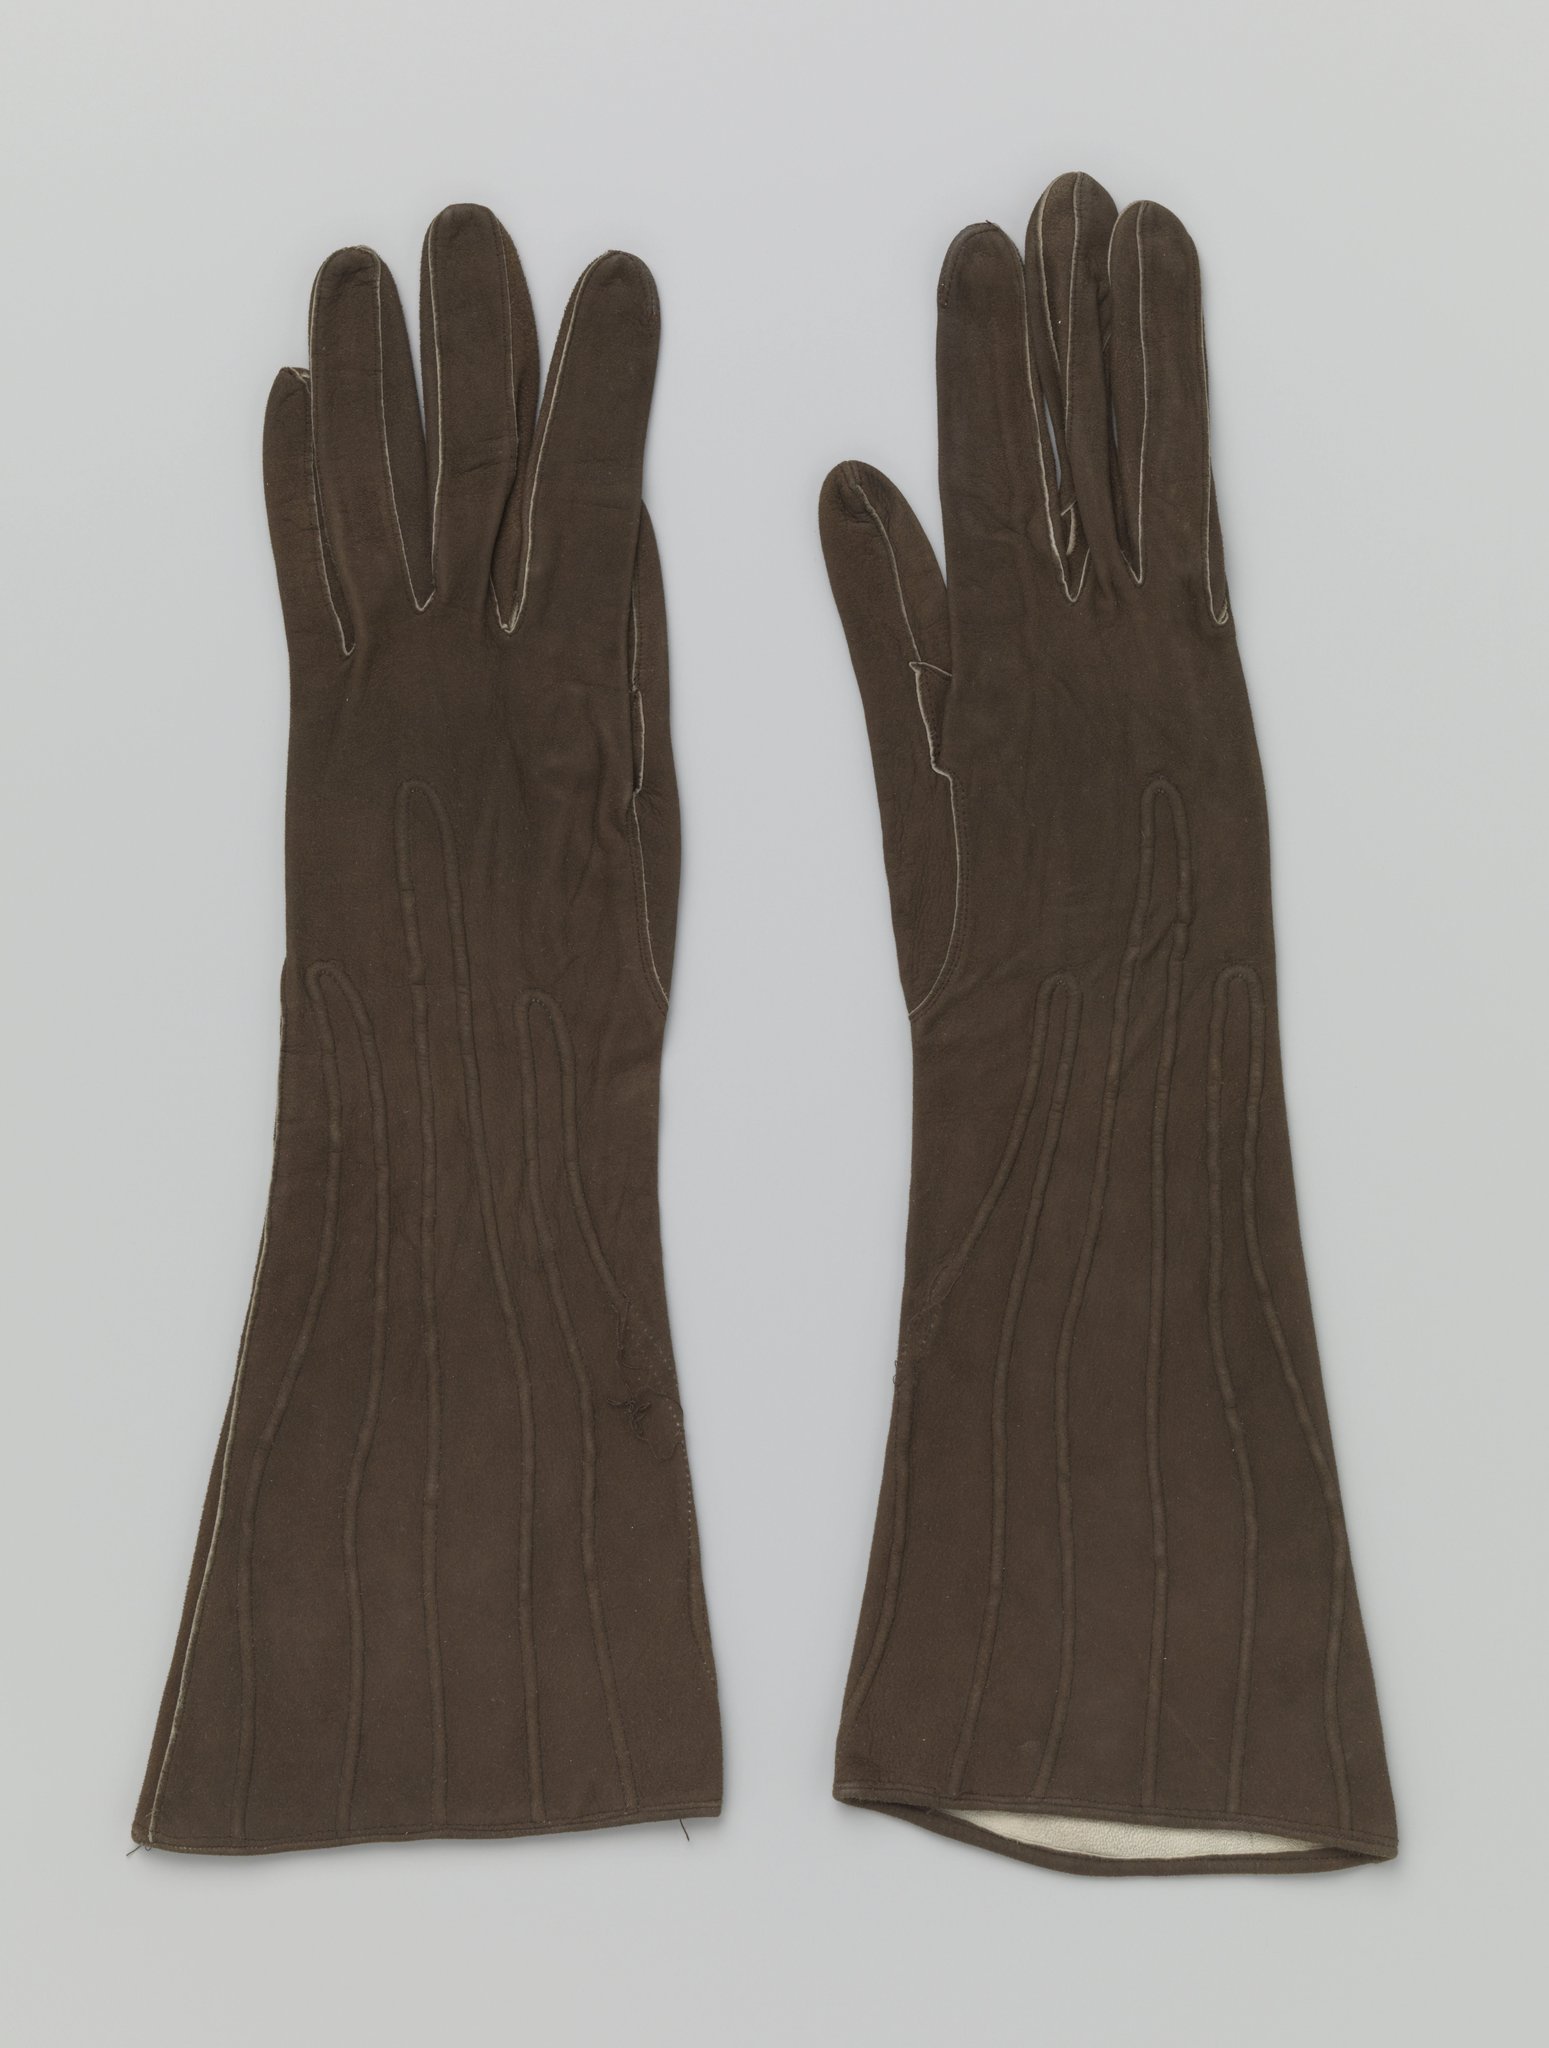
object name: glove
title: Handschoen van bruine suede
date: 1900-1915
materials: leather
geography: paris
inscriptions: stamp: ‘tekst’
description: Linker handschoen van bruine suede. Op de hand drie grillig gevormde verdikte koorden tot aan de kap.